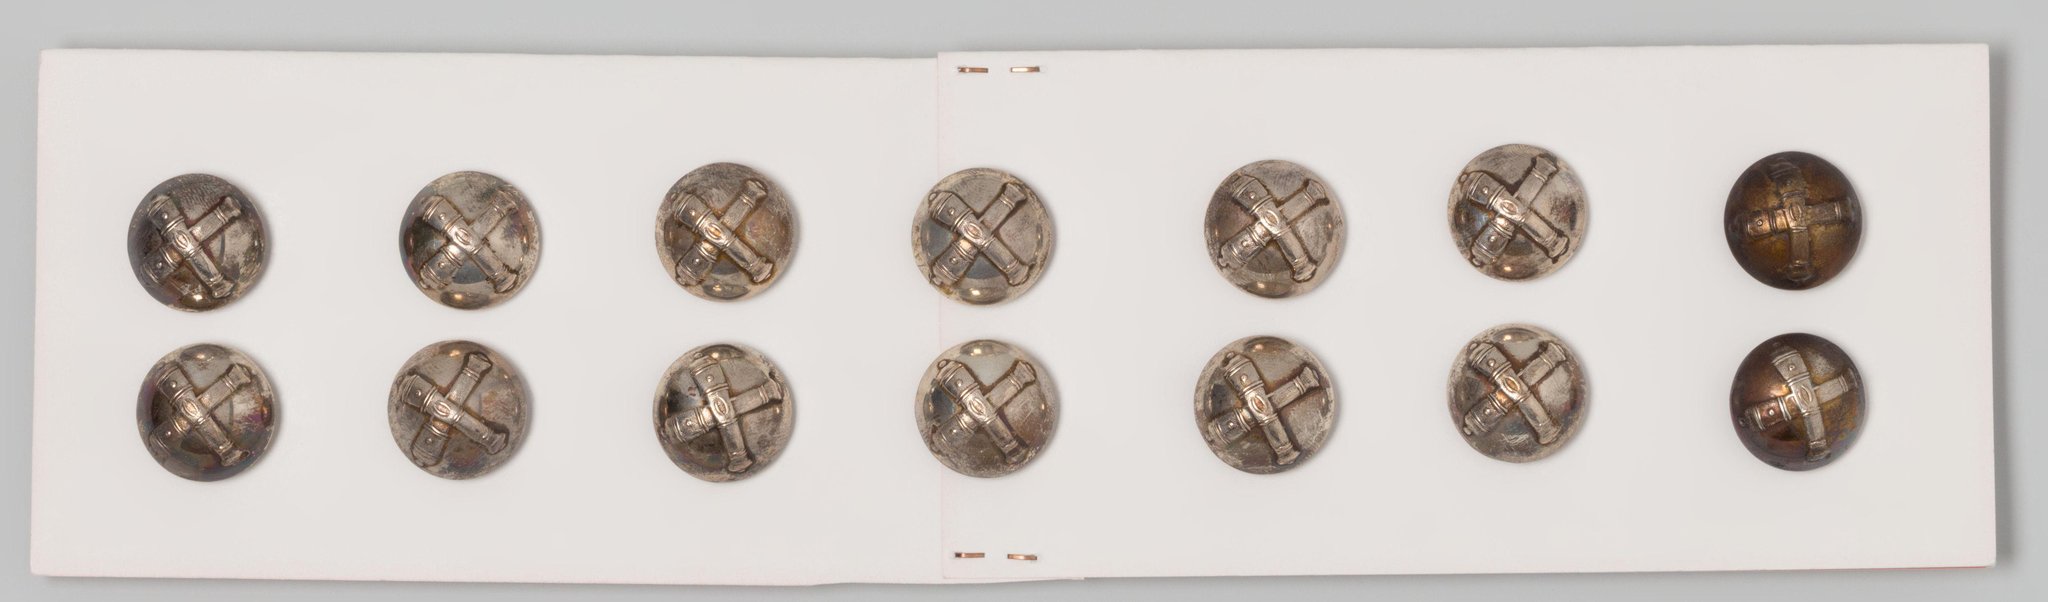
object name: menswear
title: Bolvormige knoop van verzilverd koper, waarop twee gekruiste kanonnen in reliëf; onderdeel van een artillerie-uniform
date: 1885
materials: copper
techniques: silvering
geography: the hague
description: Geborgen in een doos bij een sjerp; notitie in doos: "W. Six 1859-1928/14 knoopen schutterij uniform/1885".